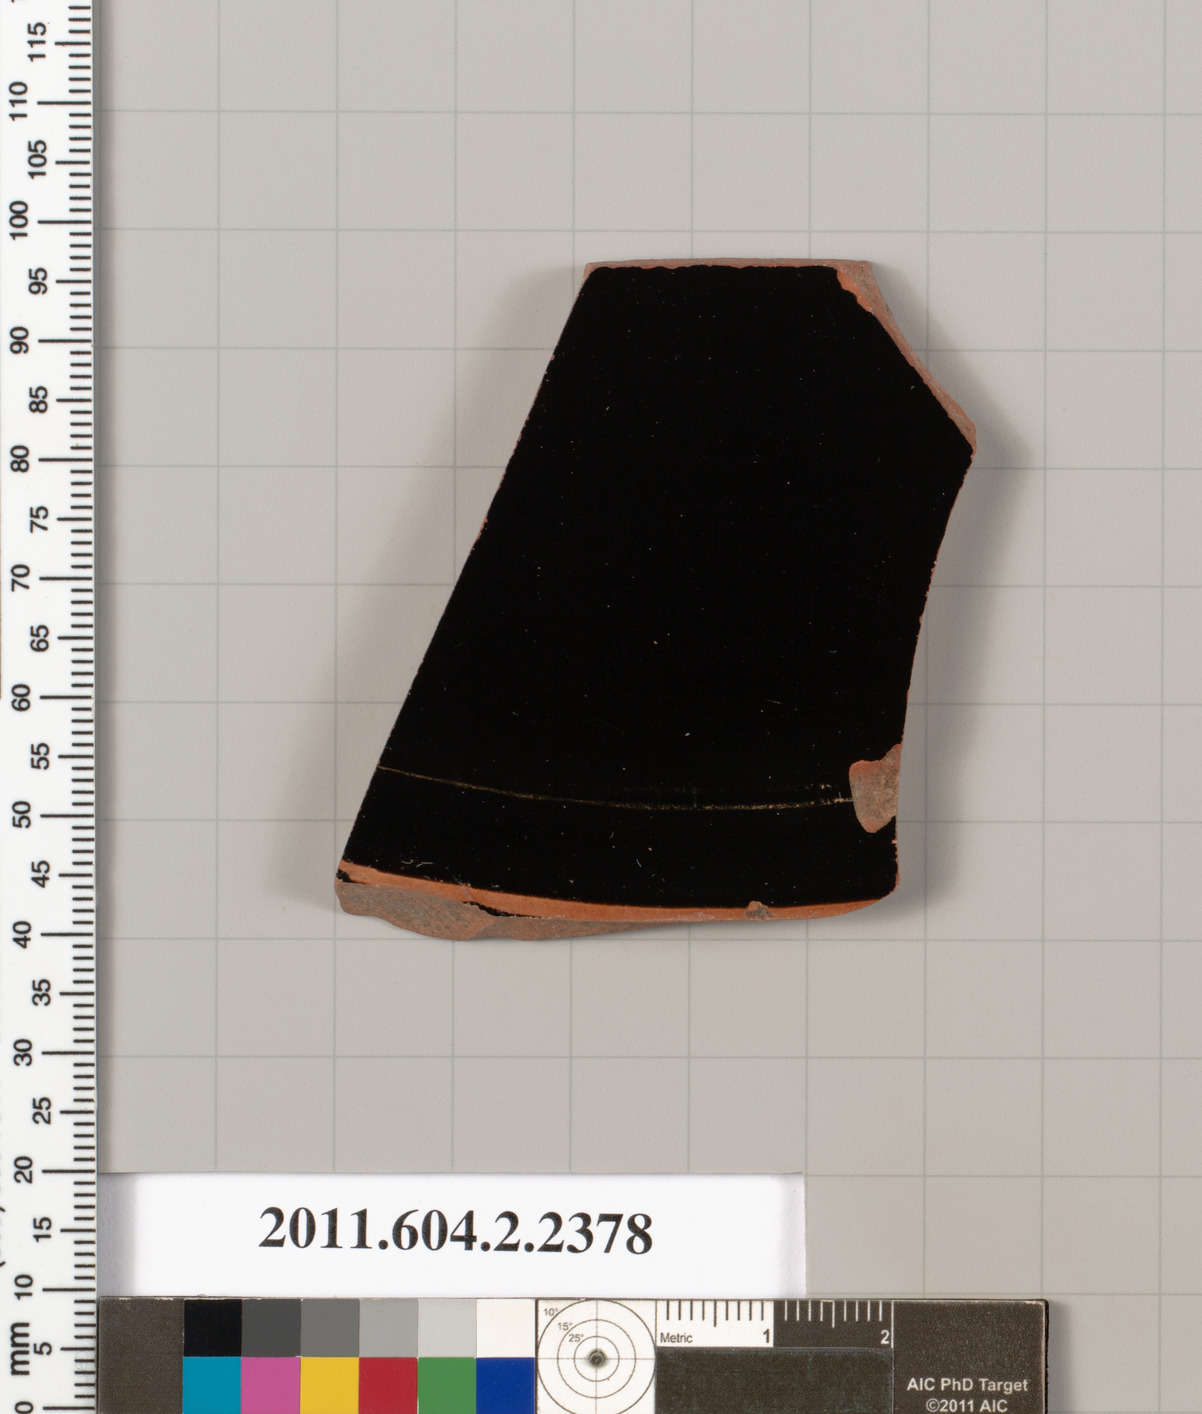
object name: lid fragment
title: Terracotta fragment of a lid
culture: greek, attic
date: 600-401 BCE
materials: terracotta